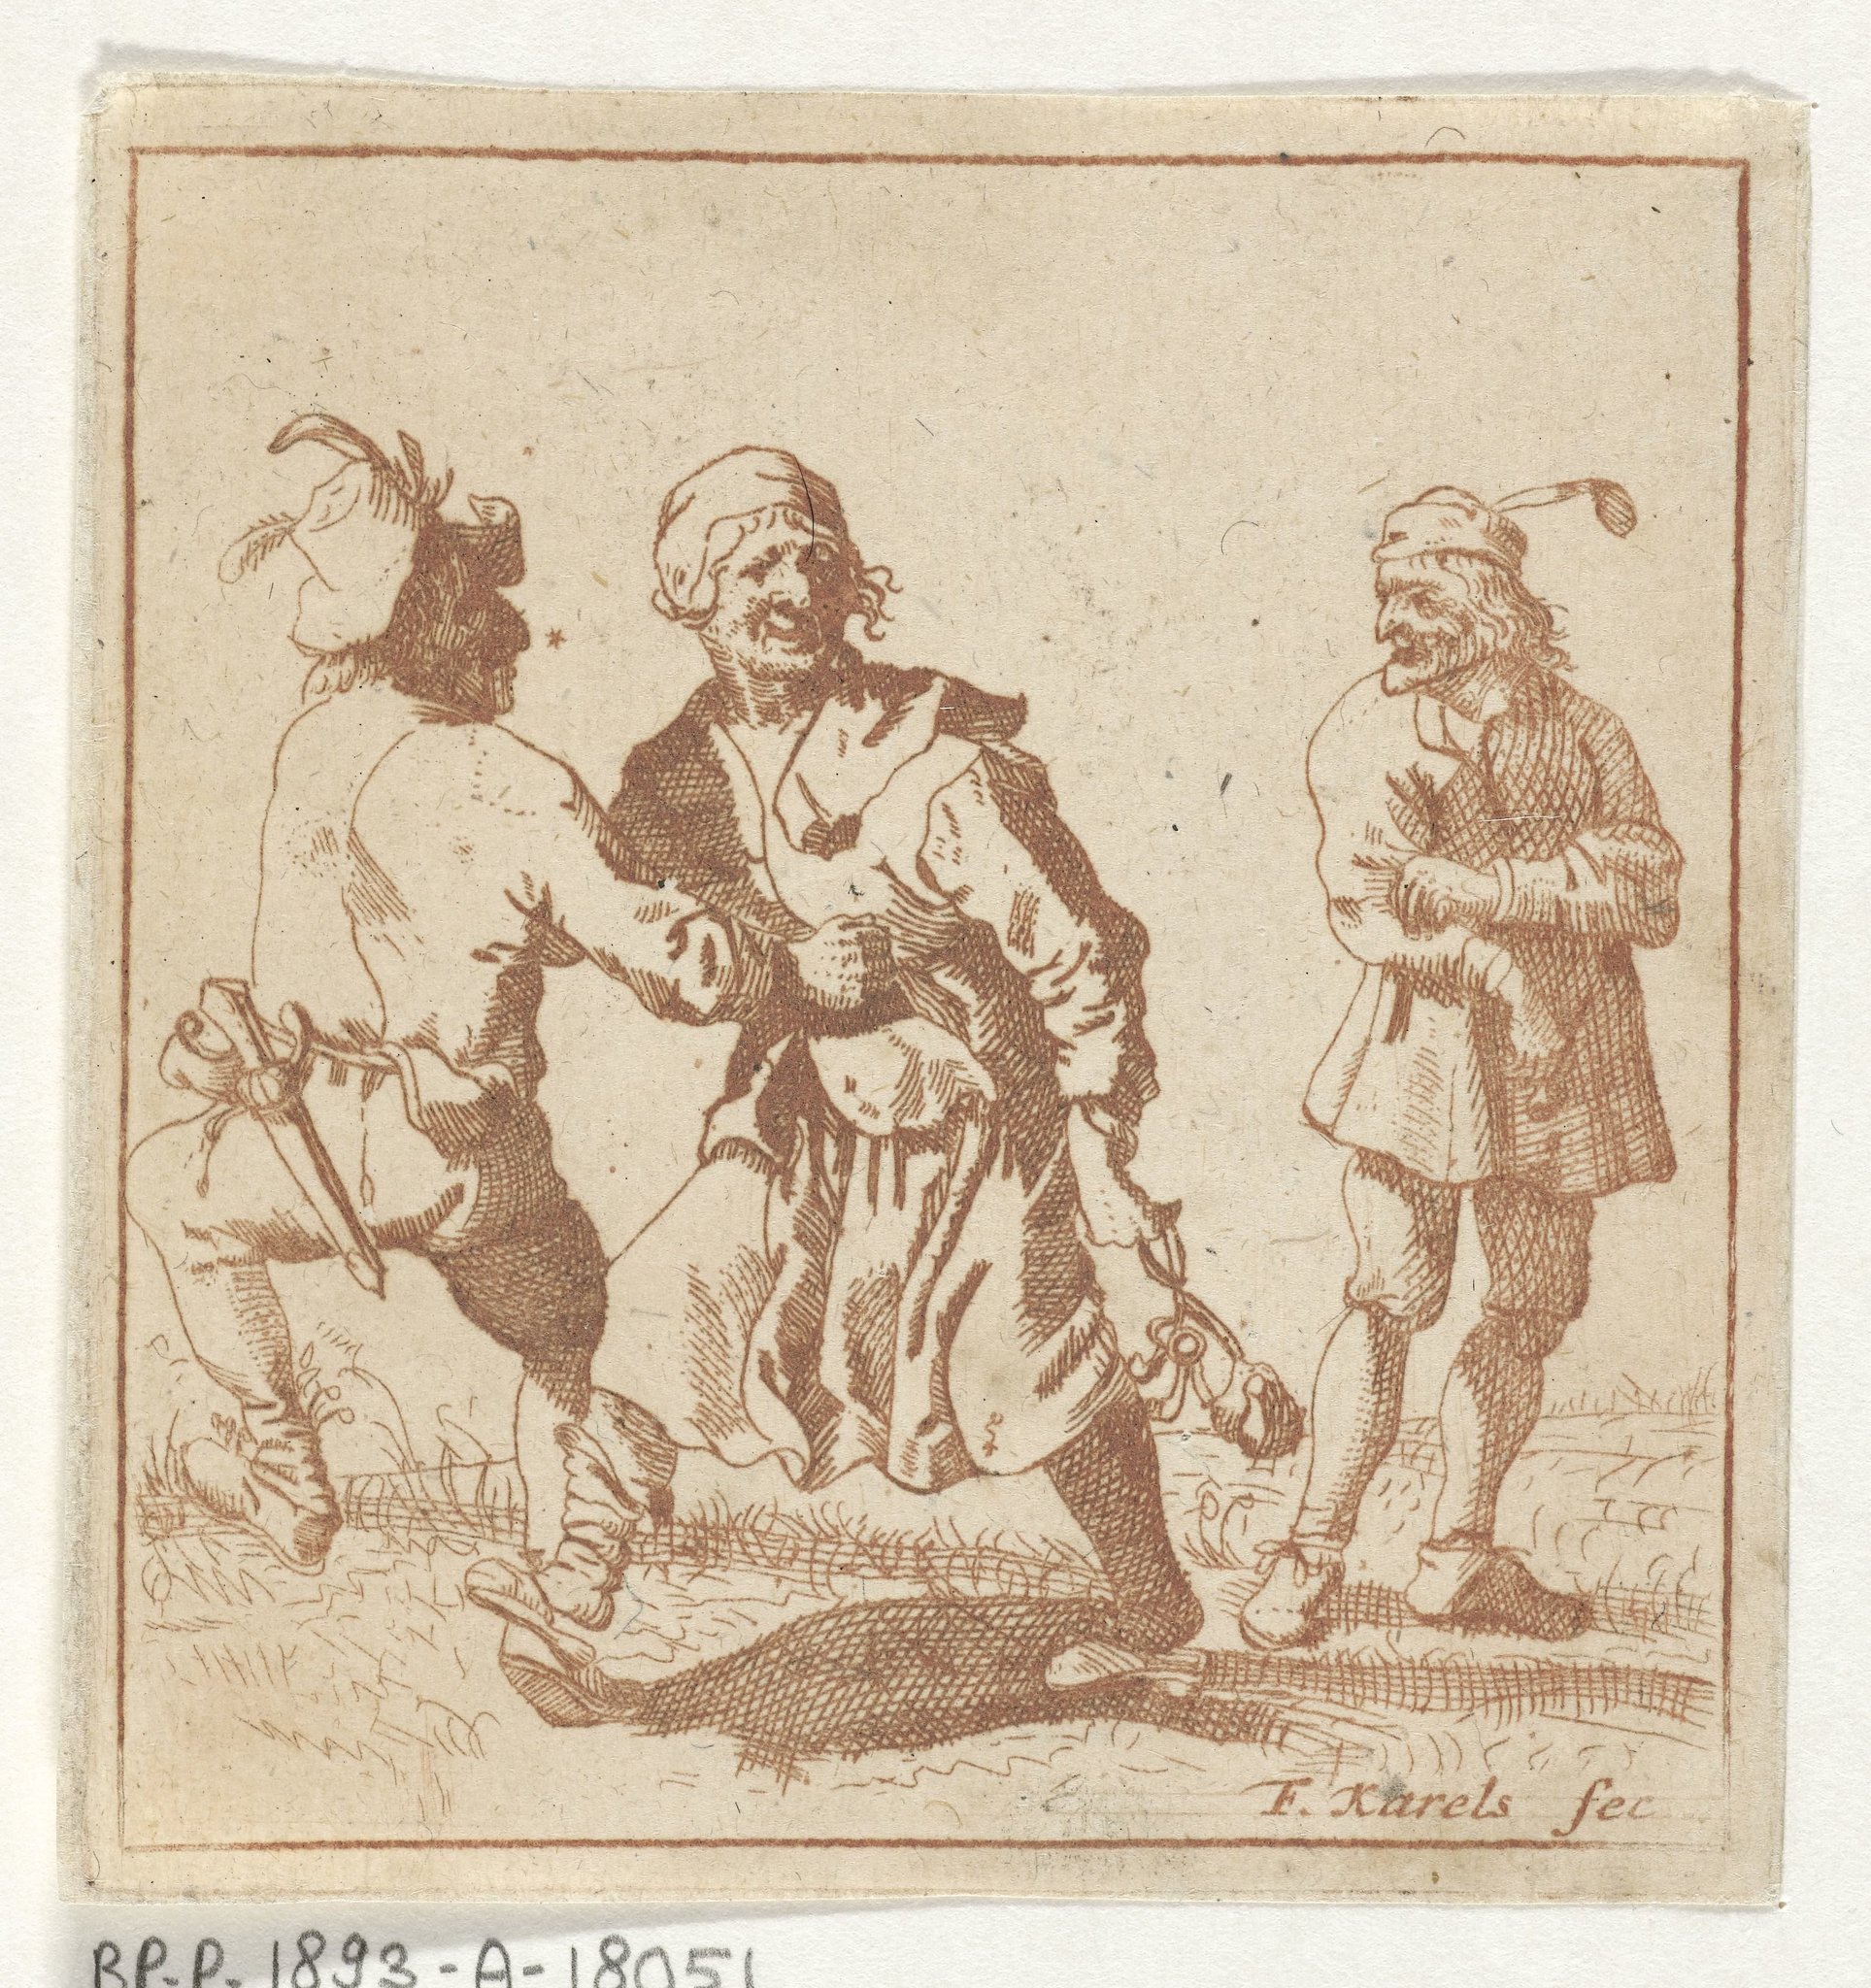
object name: print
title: Dansende boer en boerin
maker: f. karels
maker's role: print maker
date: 1700-1800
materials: paper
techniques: etching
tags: pipe ~ tobacco, folk dancing (men and women together)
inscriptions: collector's mark: Lugt 2228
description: Twee dansende boeren, een derde staat ernaar te kijken.